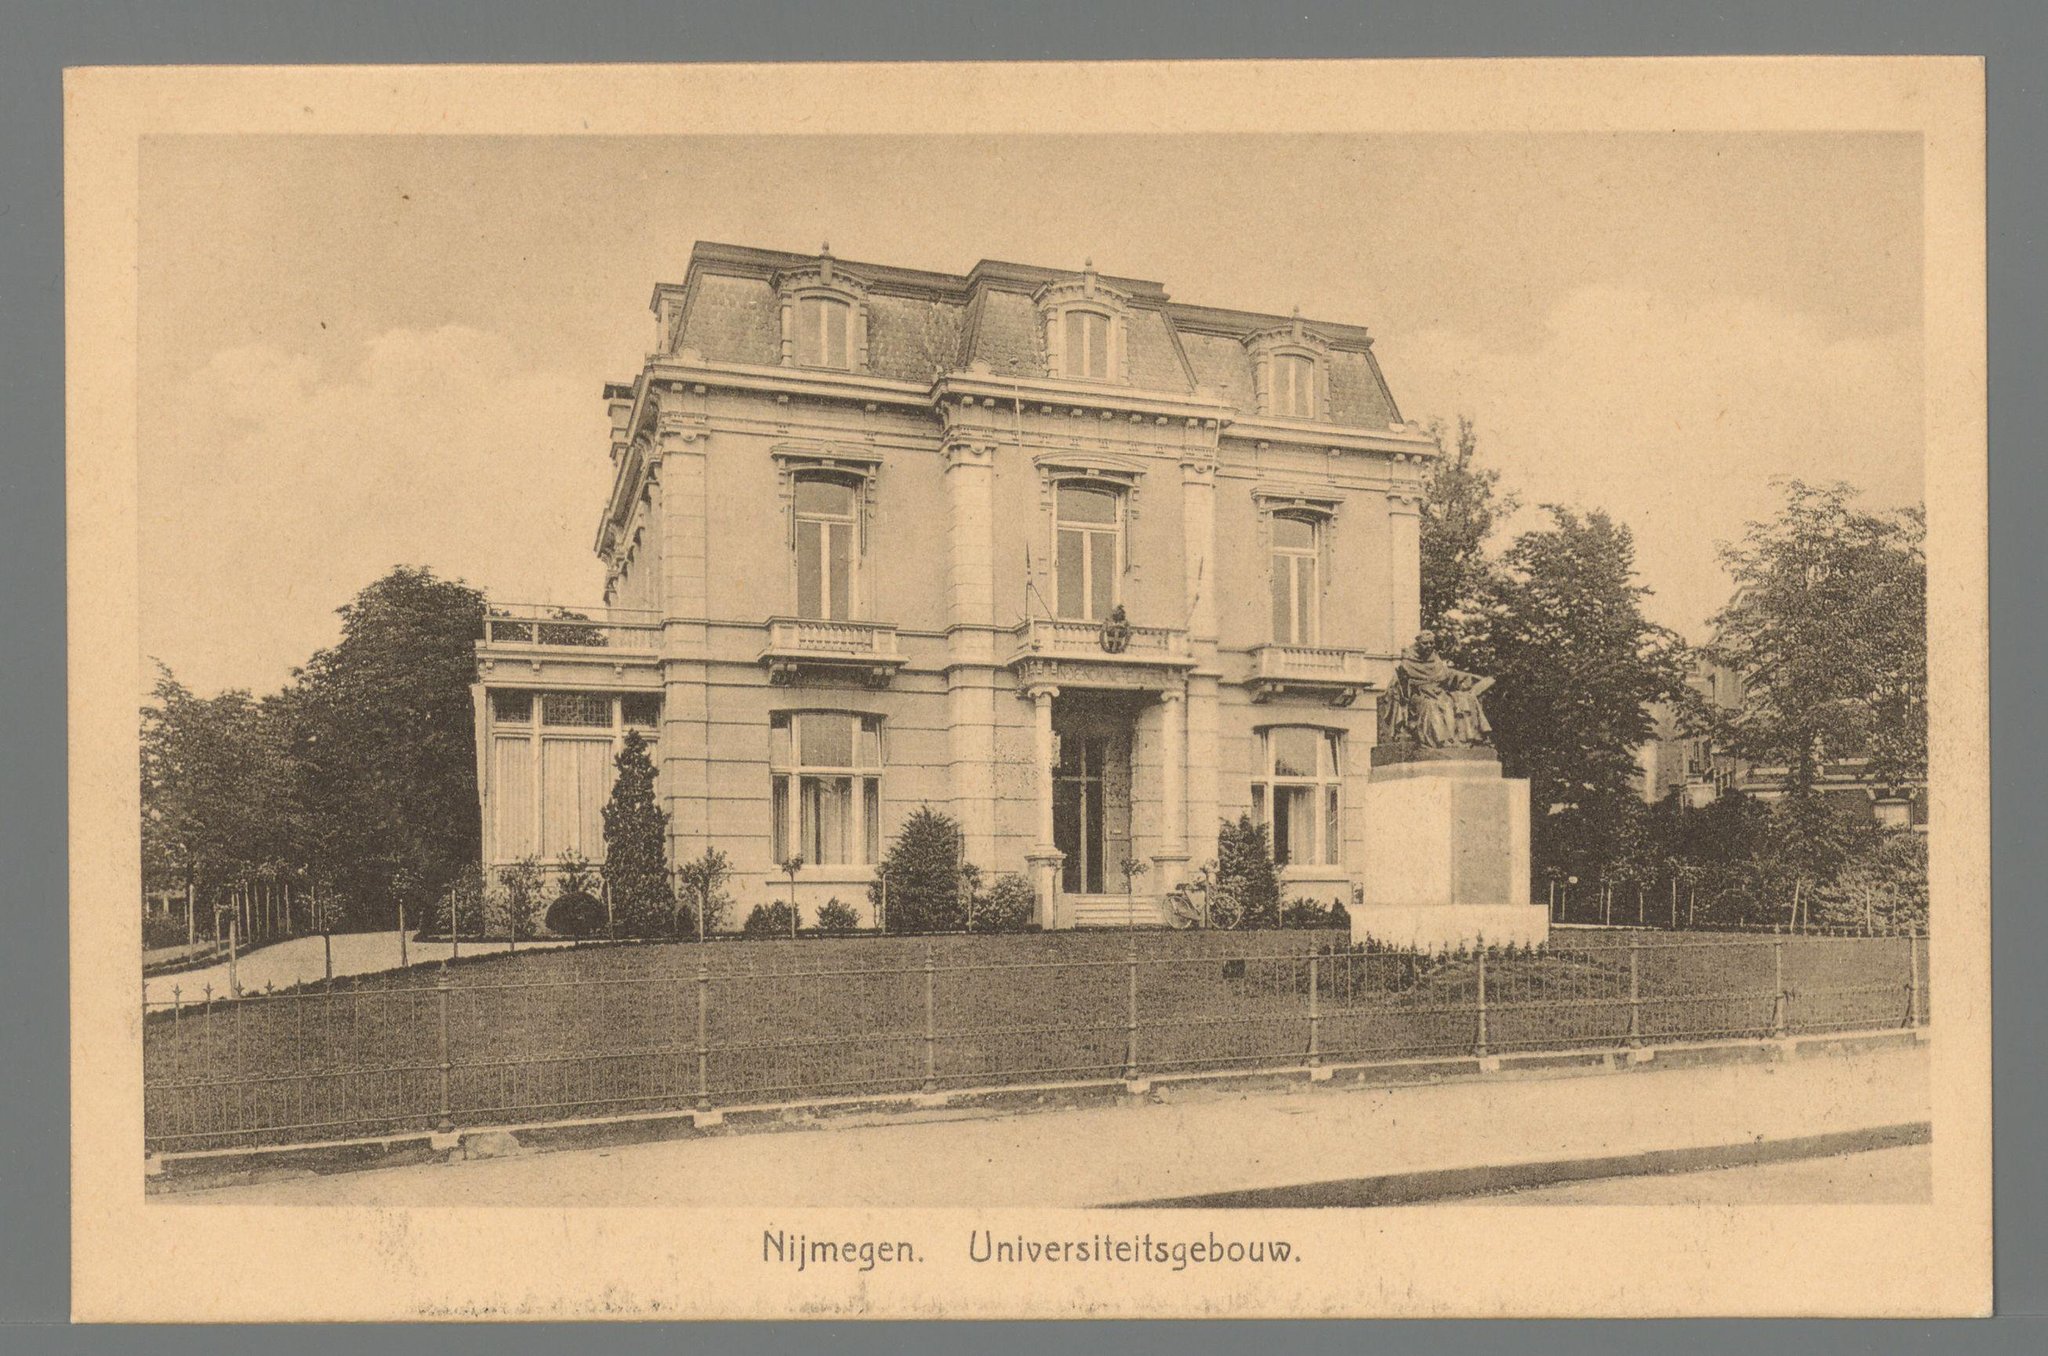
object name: photomechanical print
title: Nijmegen. Universiteitsgebouw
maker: Anonymous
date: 1927-1935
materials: cardboard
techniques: photograph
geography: the hague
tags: university building, college, nijmegen